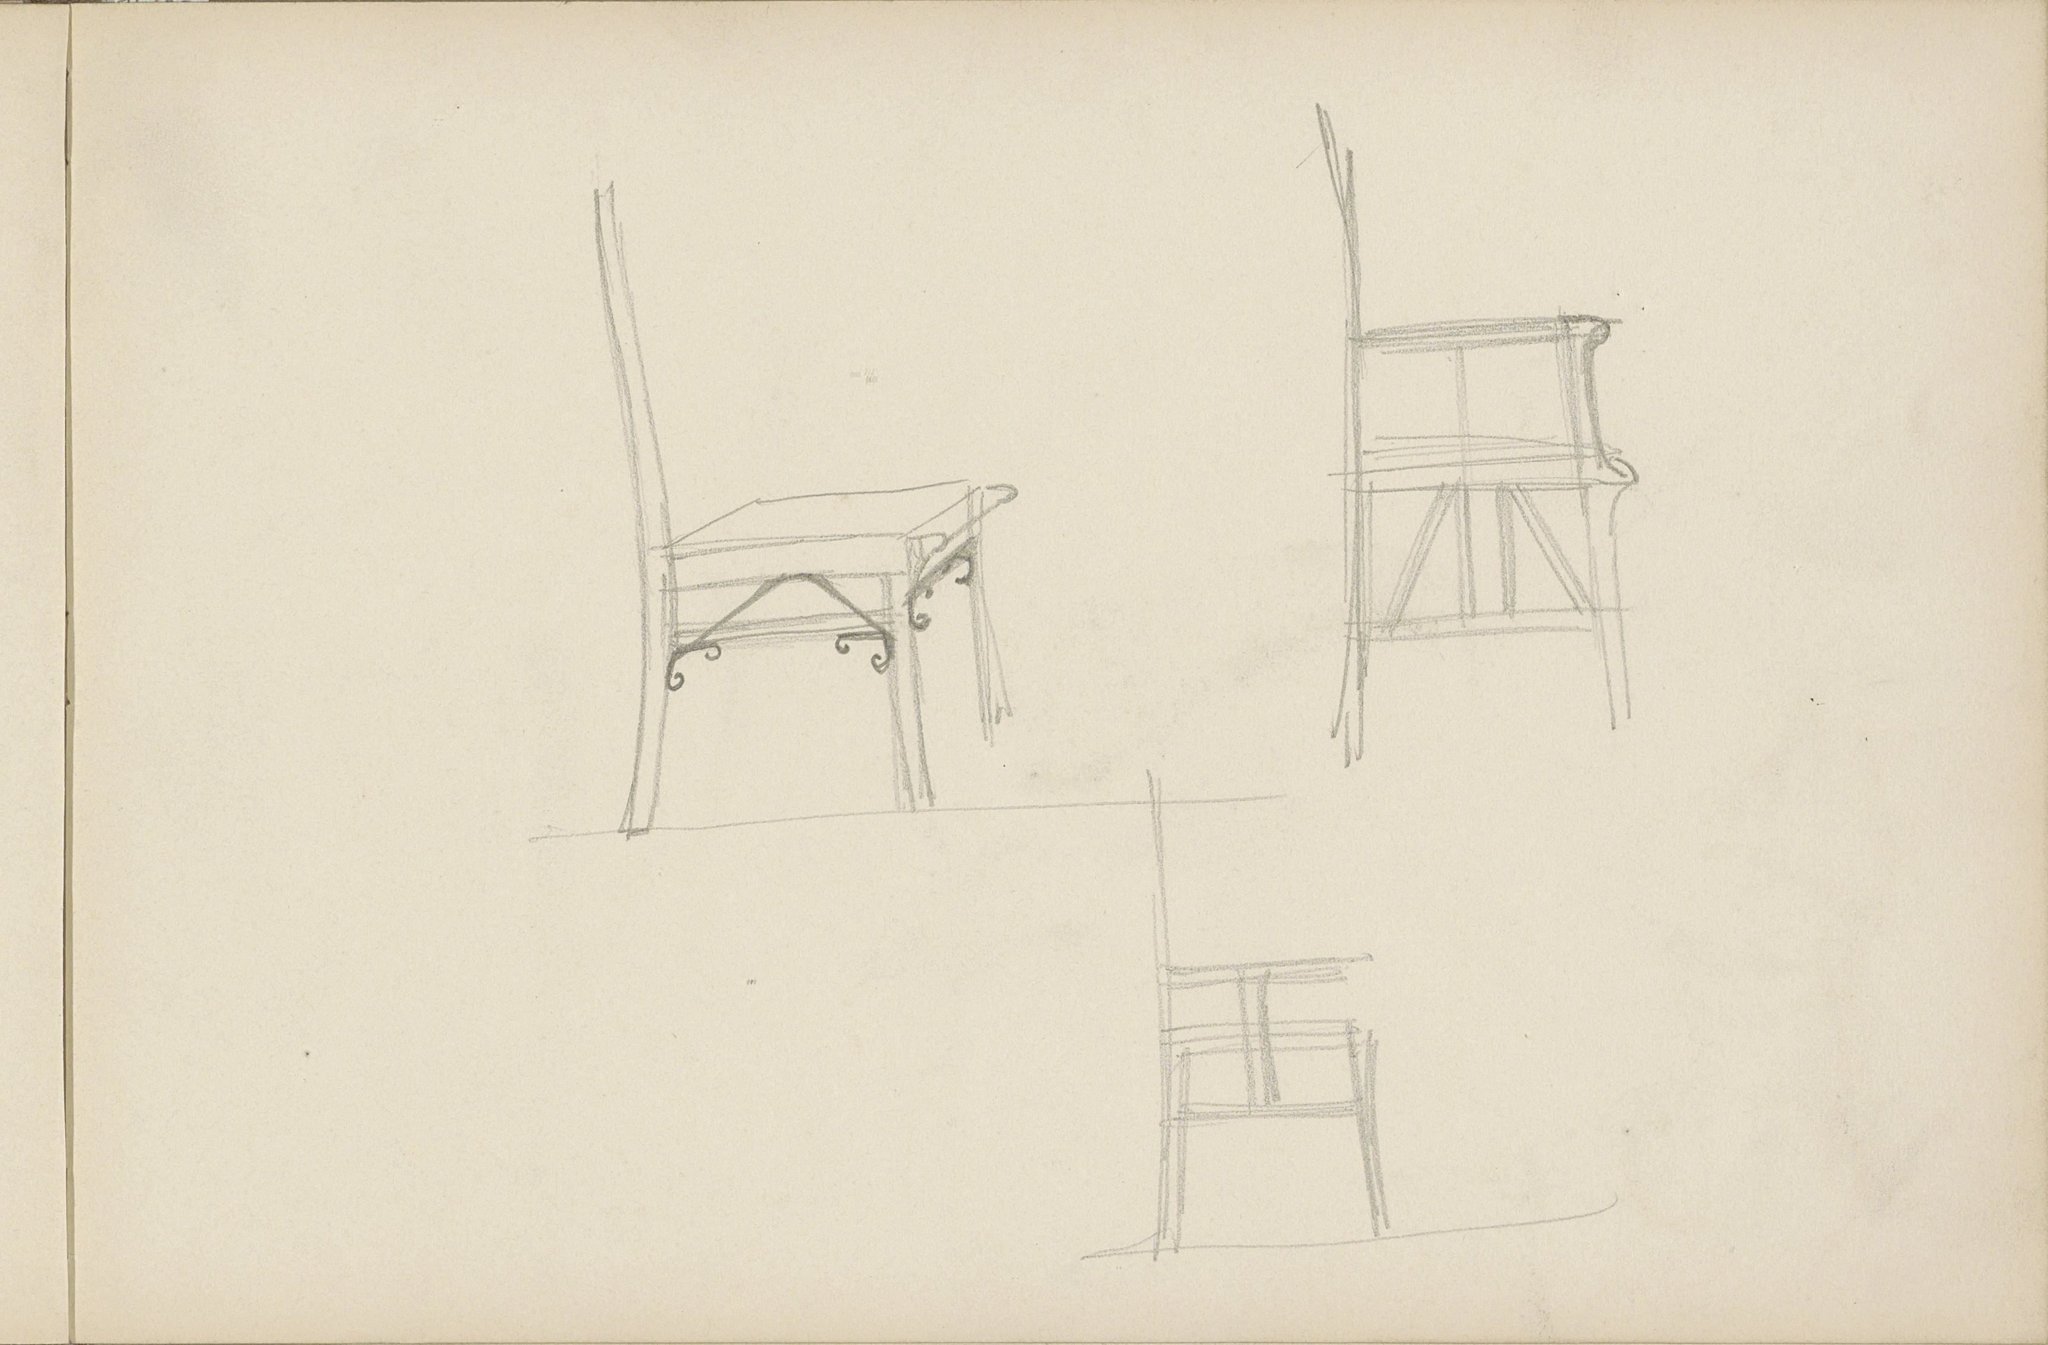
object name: sketchbook leaf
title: Ontwerpen voor een stoel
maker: carel adolph lion cachet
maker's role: draughtsman, print maker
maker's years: 1864-1945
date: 1908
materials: paper, pencil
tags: chair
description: Blad 10 recto uit een schetsboek met 25 bladen.